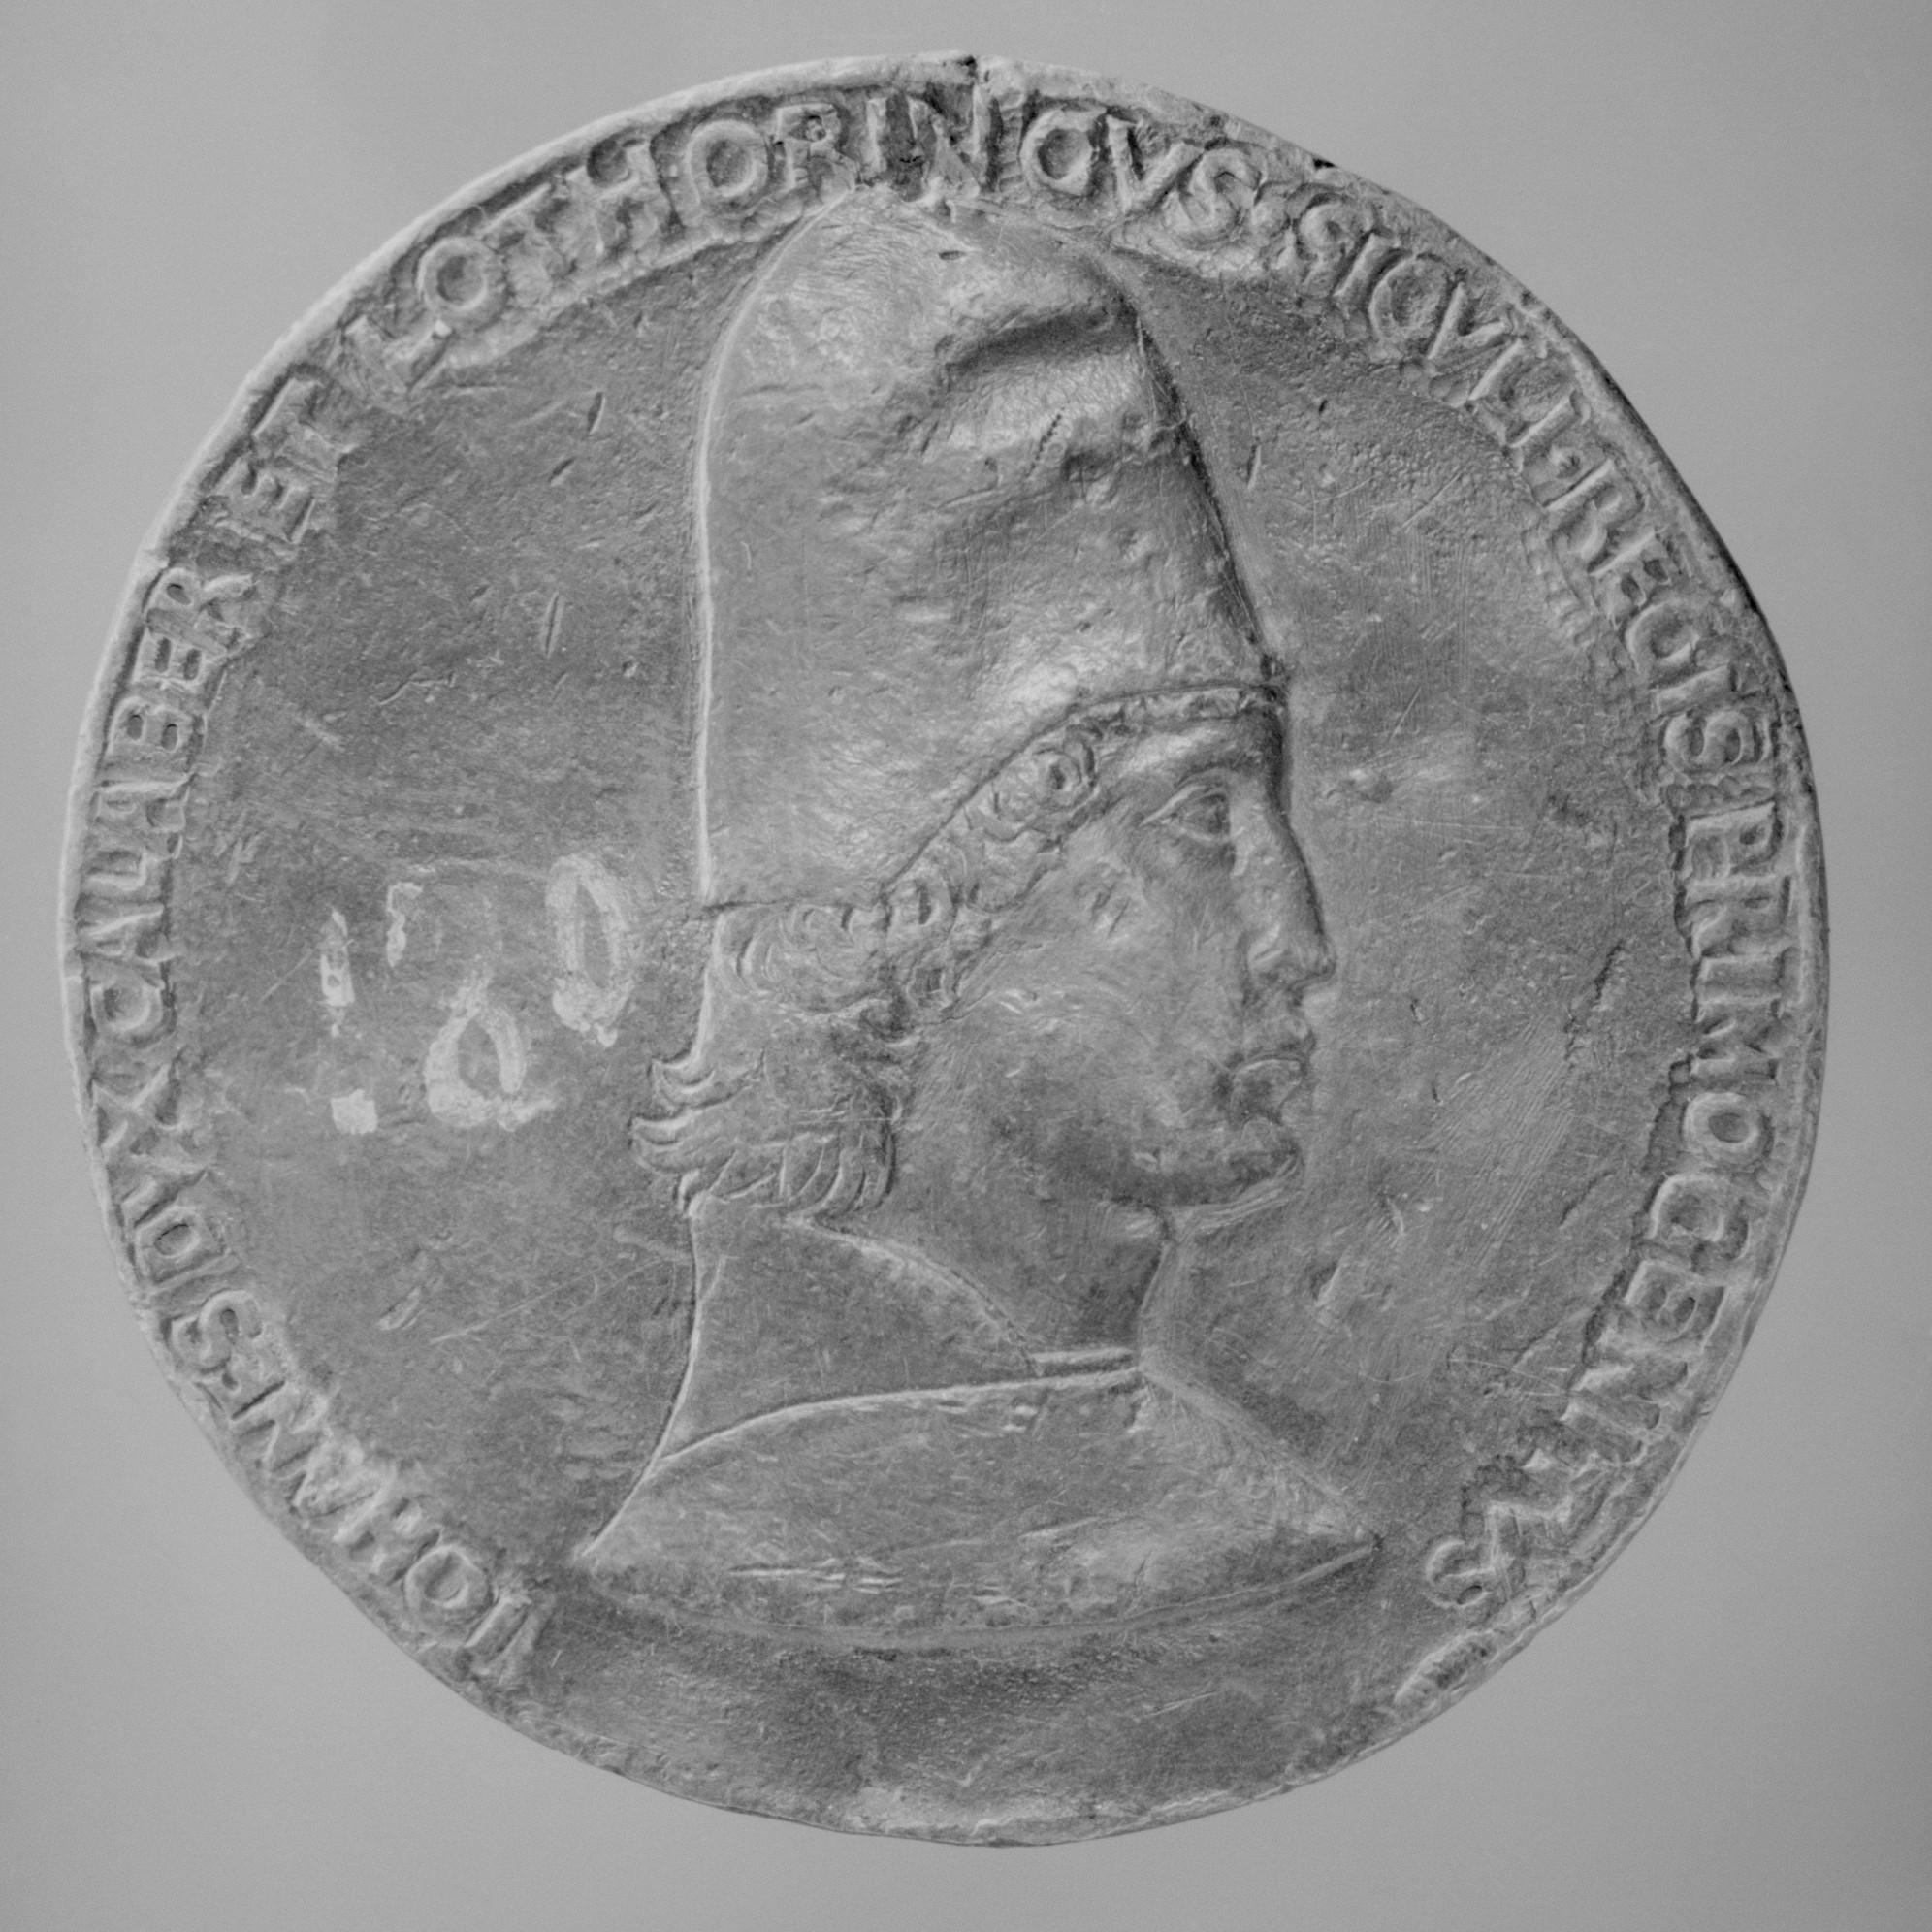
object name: medal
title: Jean d'Anjou, Duke of Calabria and Lorraine (1427–1470)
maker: francesco laurana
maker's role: artist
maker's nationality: italian, born croatia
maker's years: 1415-1507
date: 1464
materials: lead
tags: men,profiles